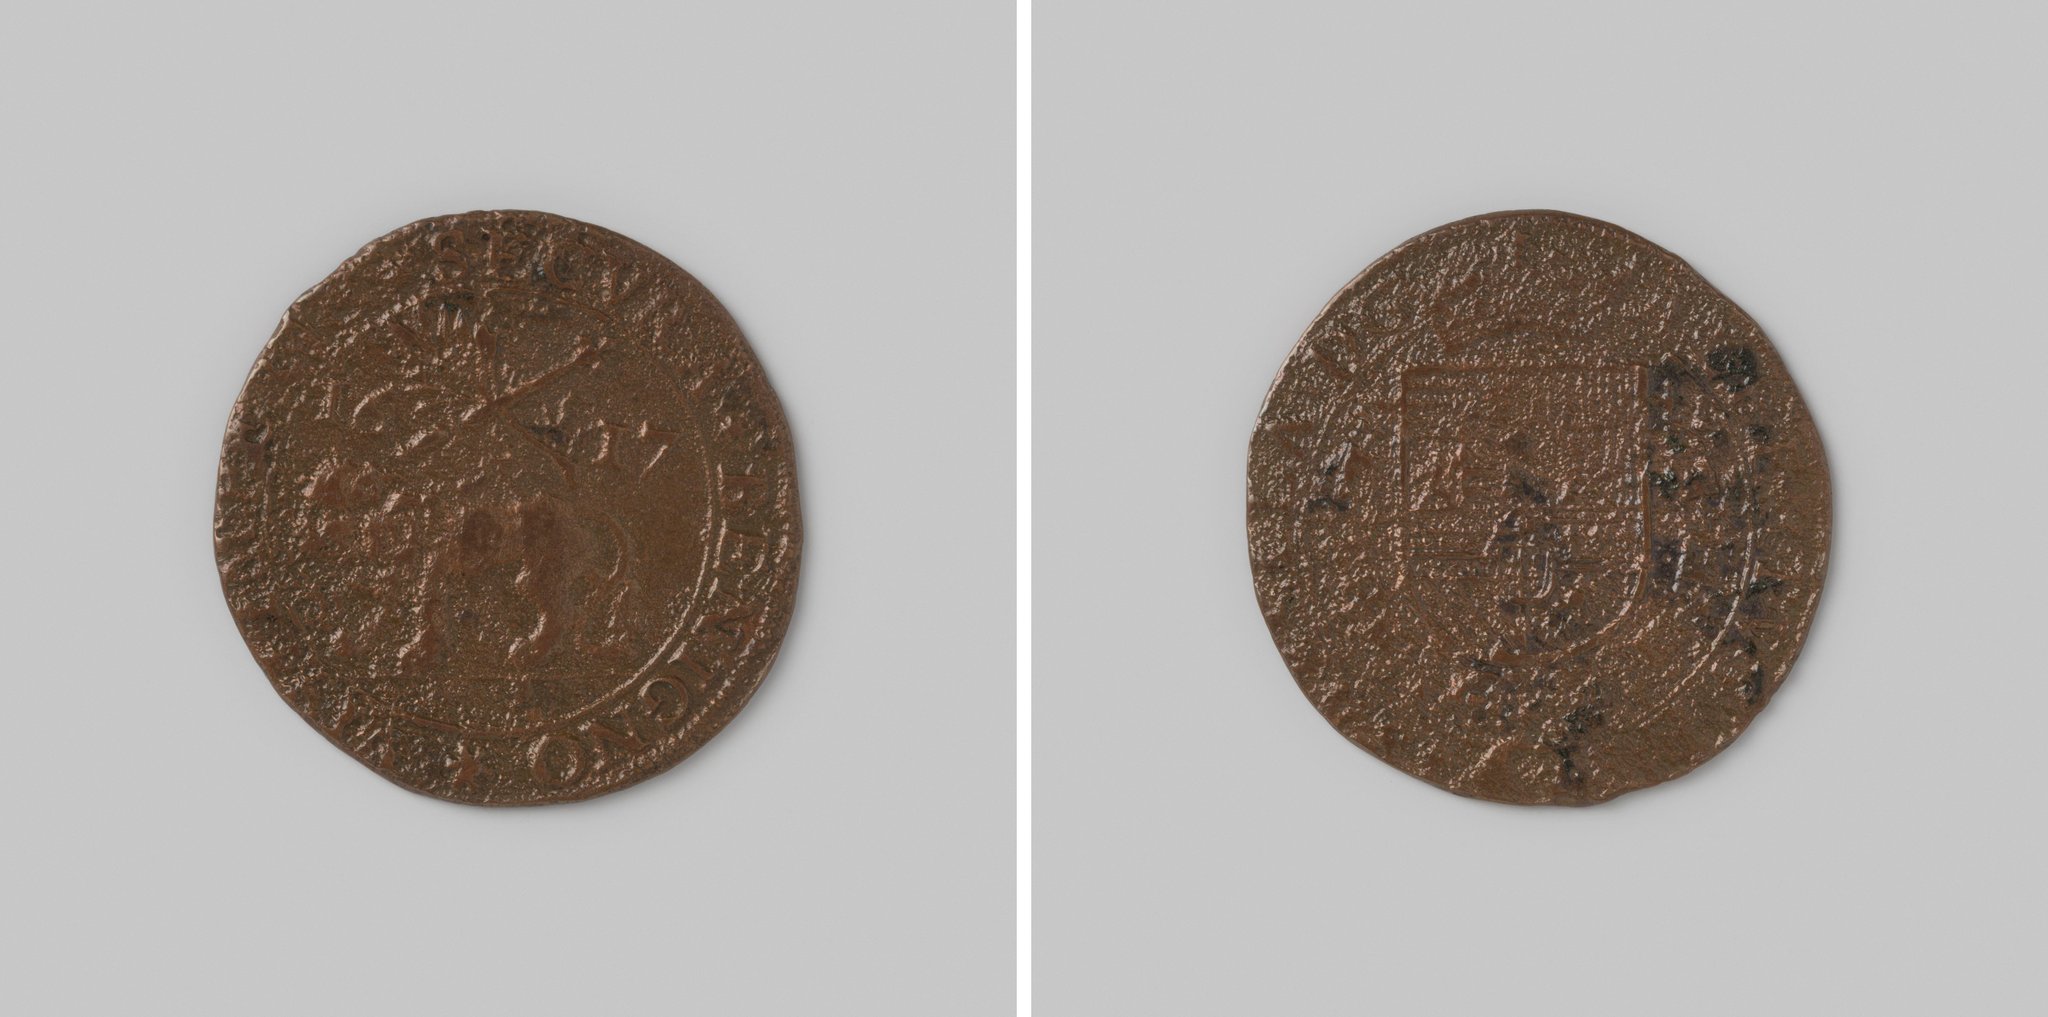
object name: jeton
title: Rekenpenning op naam van Albert en Isabella 1617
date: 1617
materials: copper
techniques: striking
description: Koperen penning, op de voorzijde een leeuw staande naar links waarboven een gekruiste scepter en palmtak, met jaartal in het veld en omschrift, op de keerzijde het gekroonde Spaanse wapenschild omhangen met de keten van het Gulden Vlies, met omschrift.